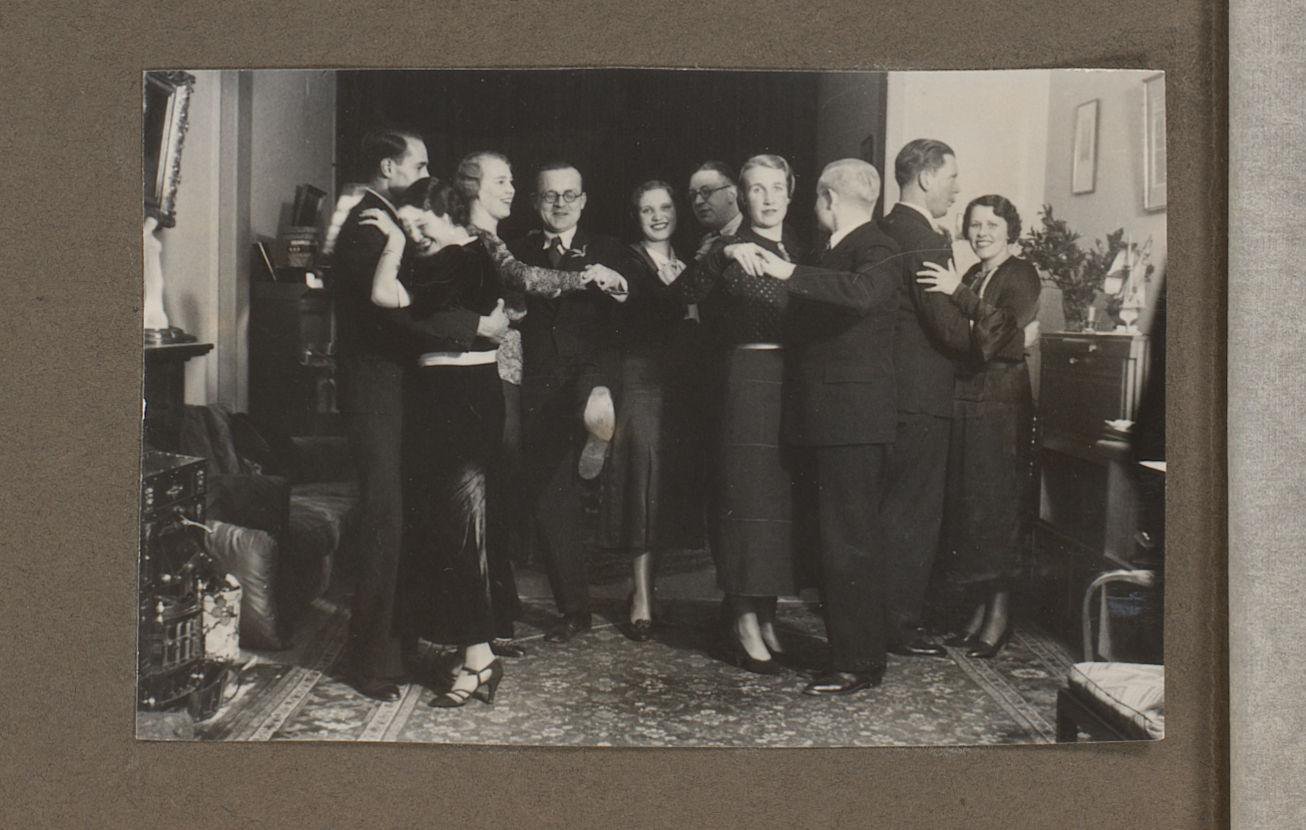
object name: album leaf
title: Gezelschap dansend in een huiskamer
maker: Anonymous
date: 1934-1935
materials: paper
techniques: gelatin silver print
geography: netherlands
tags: group dancing, private festivities, merry company, netherlands